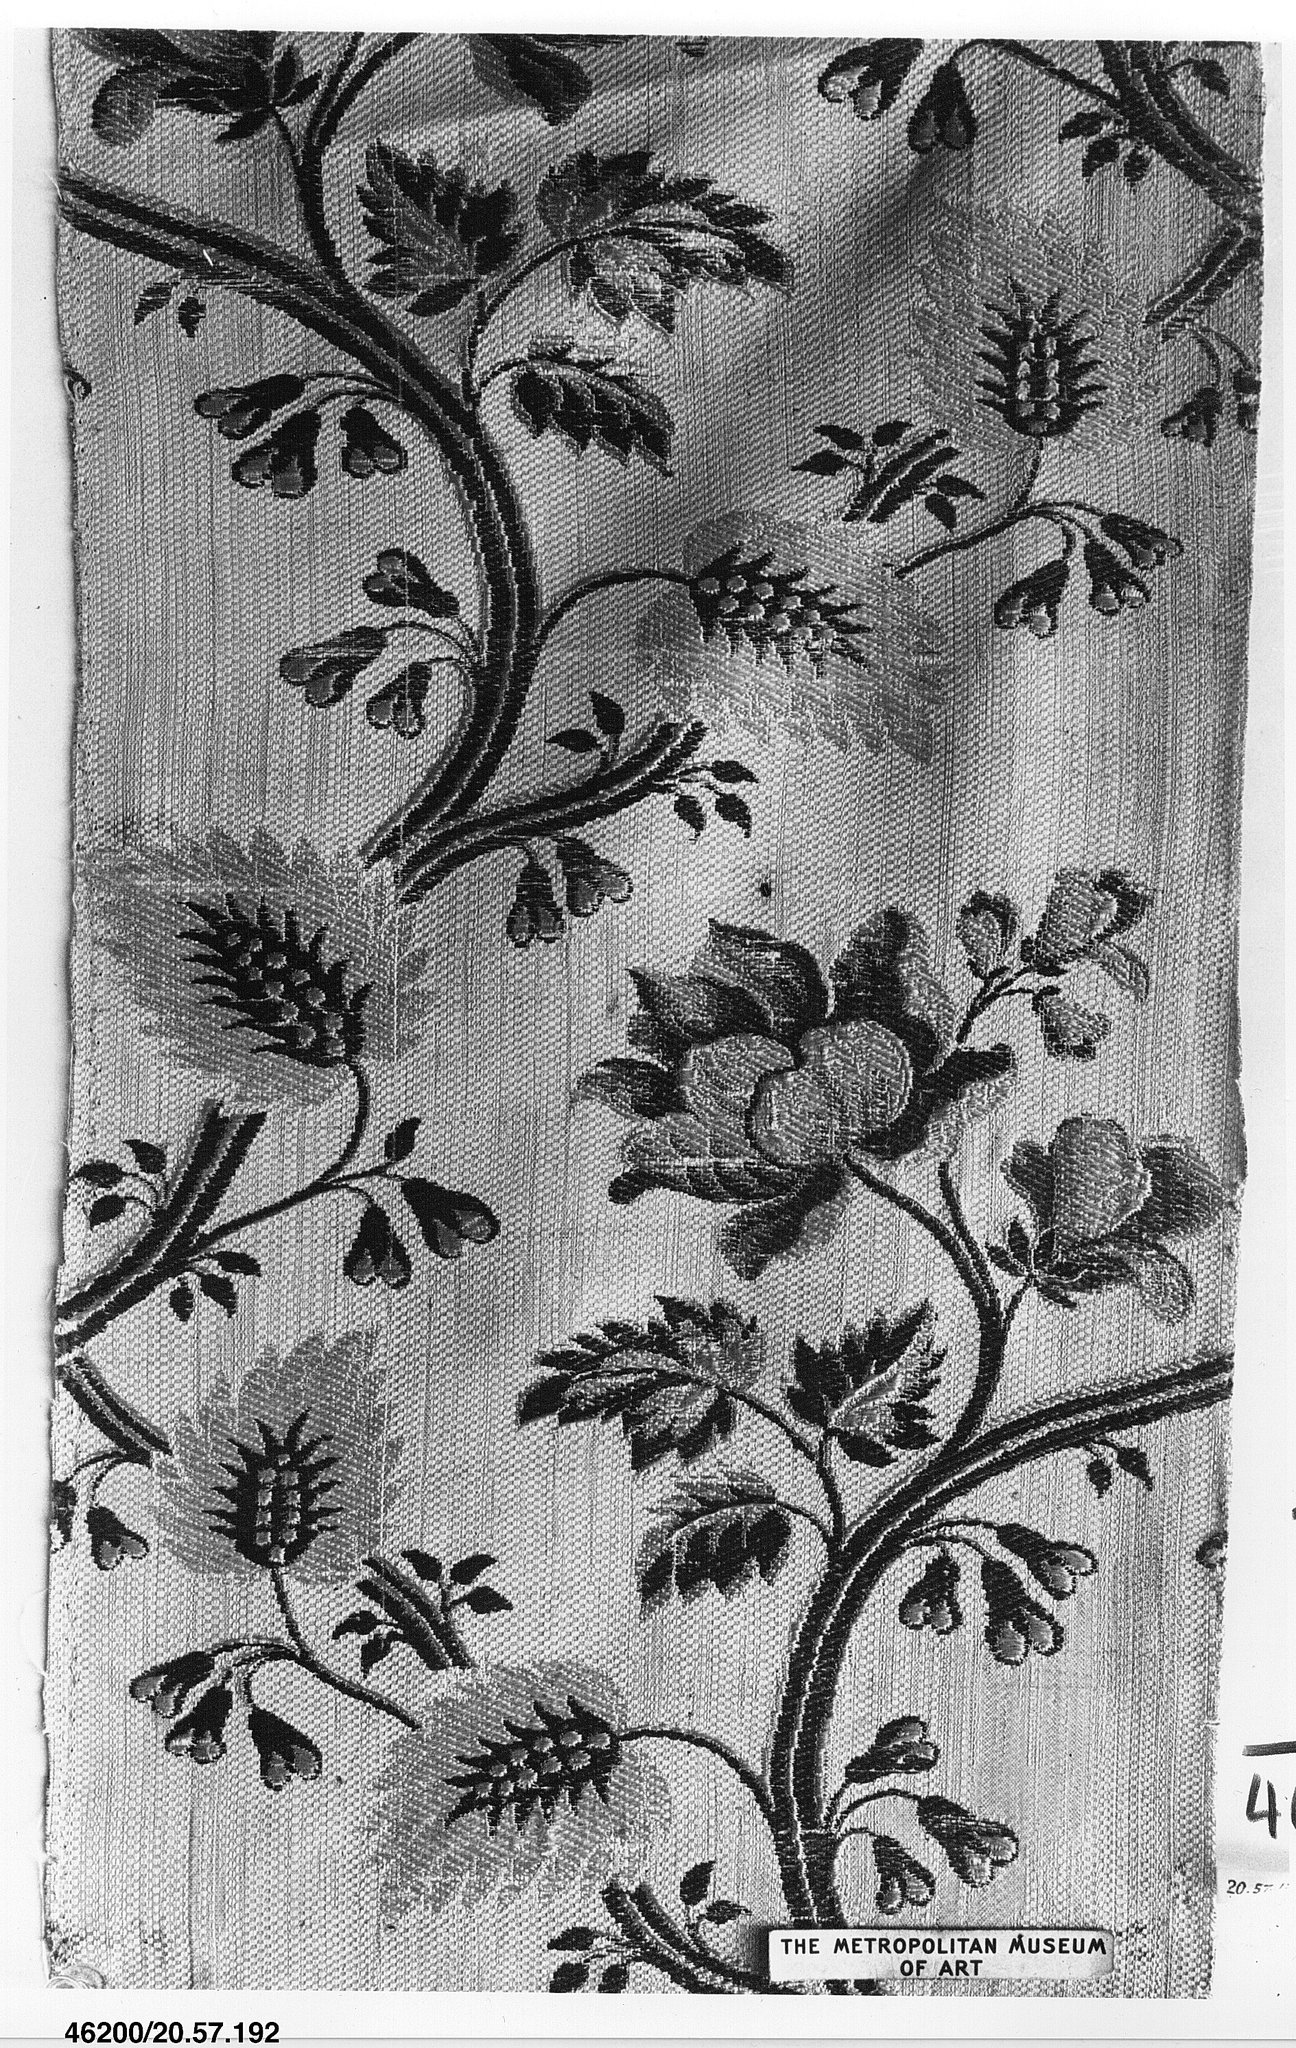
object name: brocade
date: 1740-1750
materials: silk